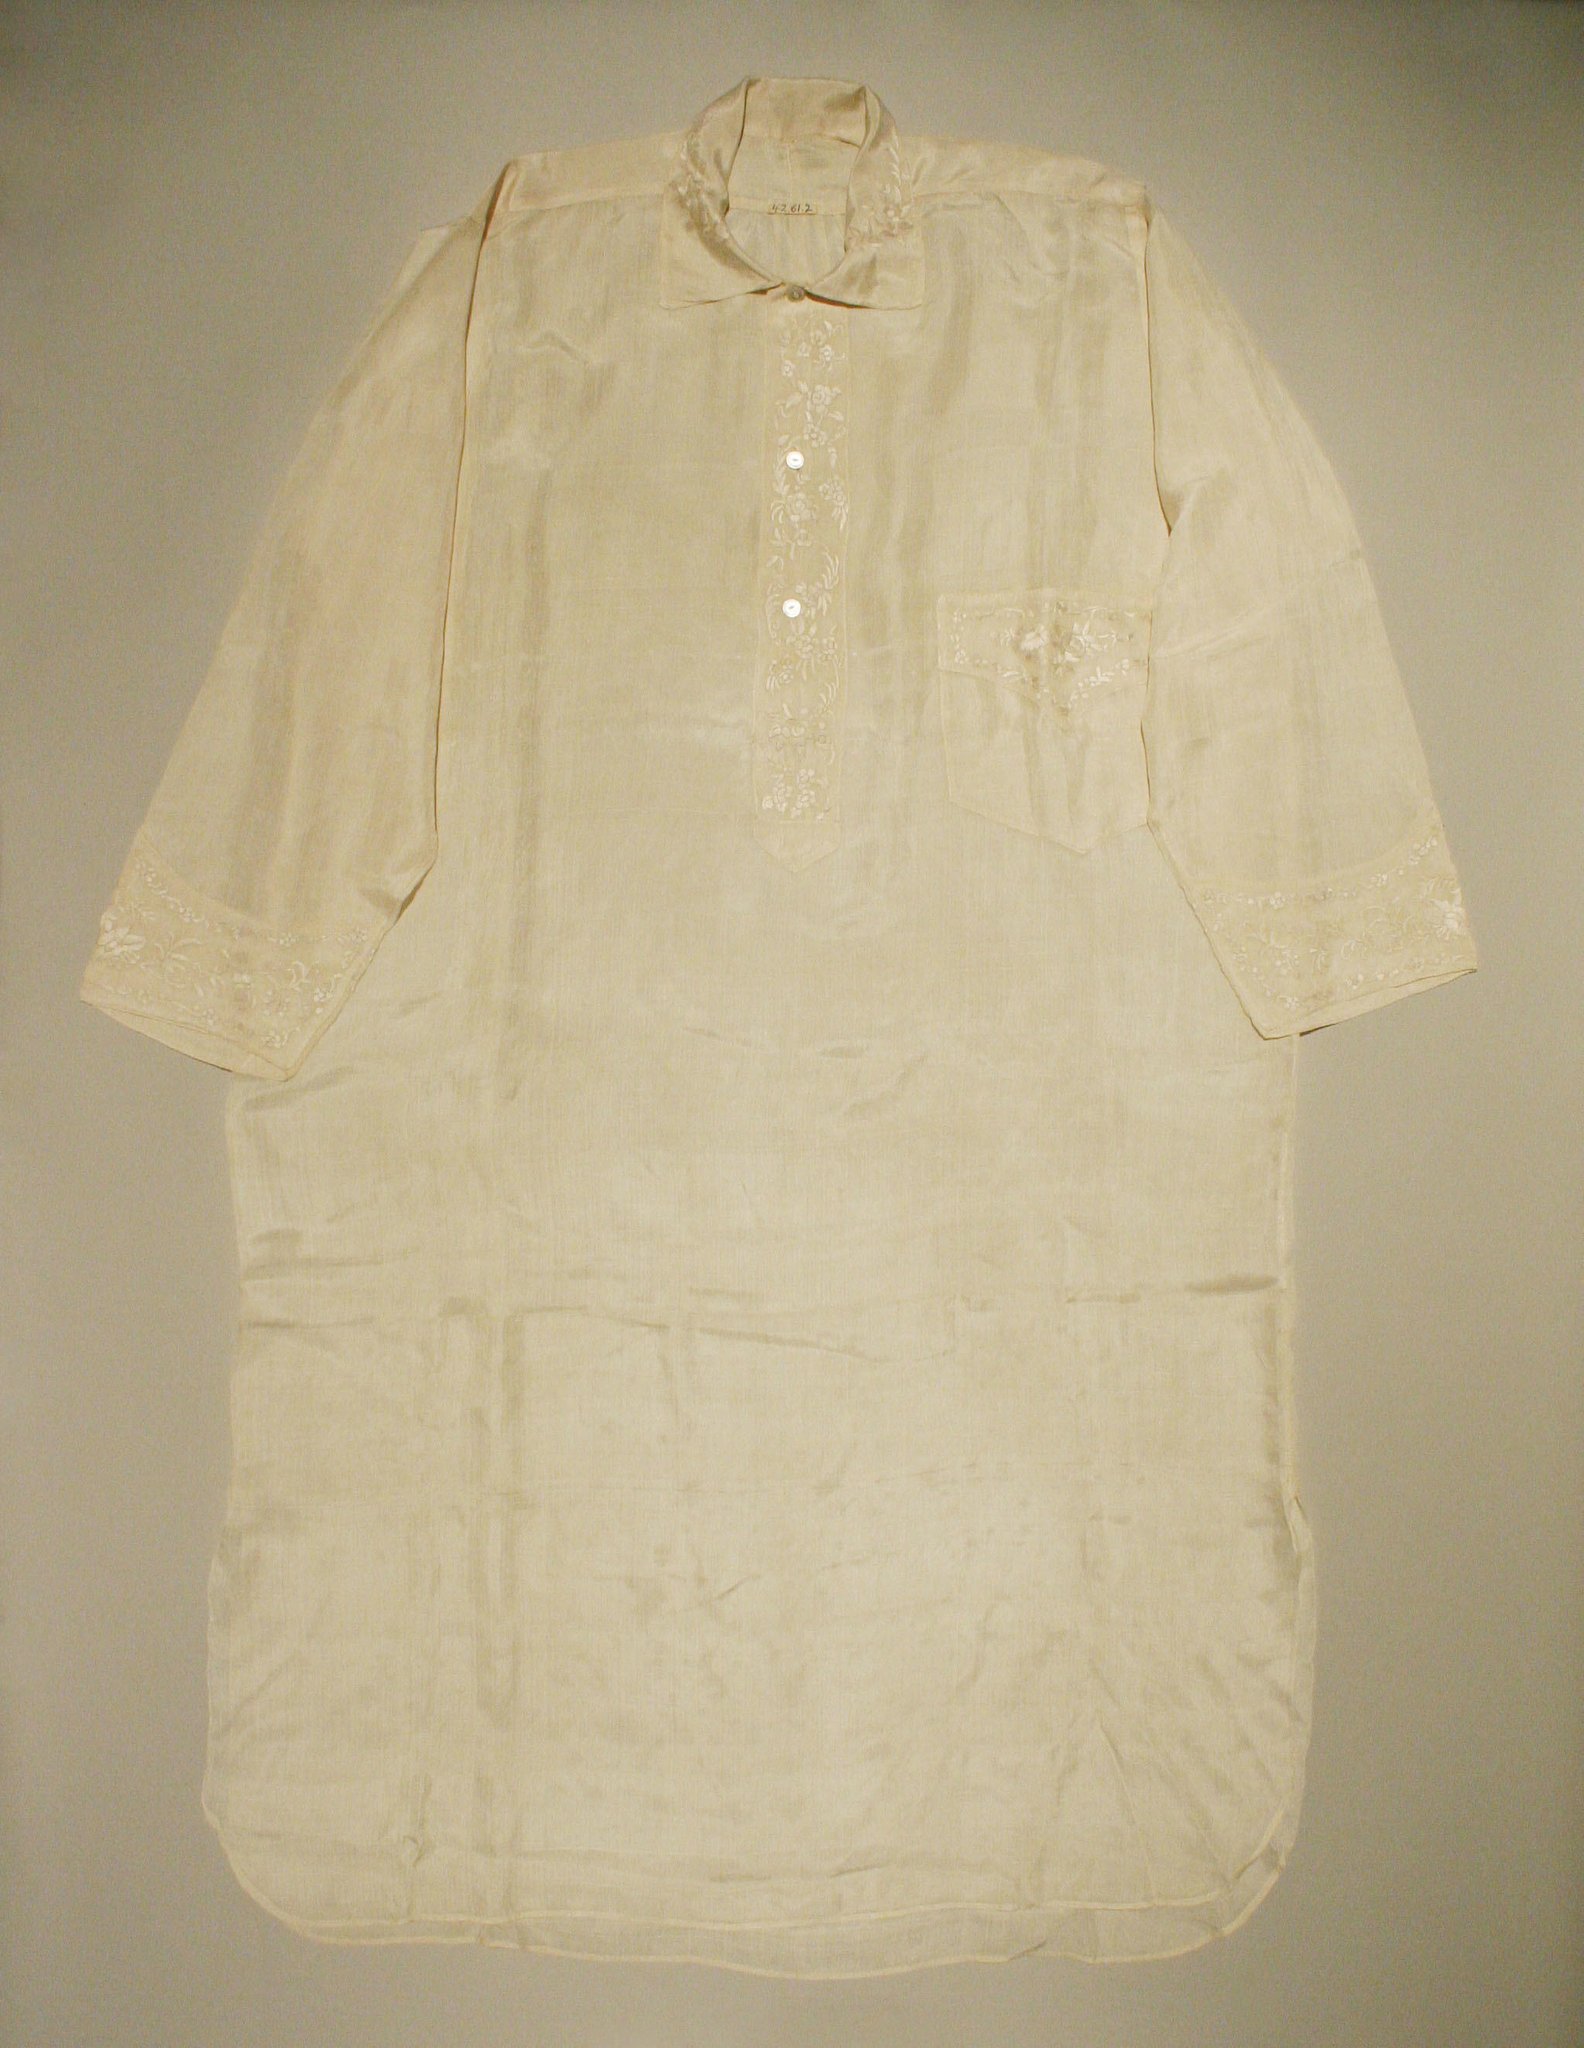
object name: wedding nightshirt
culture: american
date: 1892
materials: silk